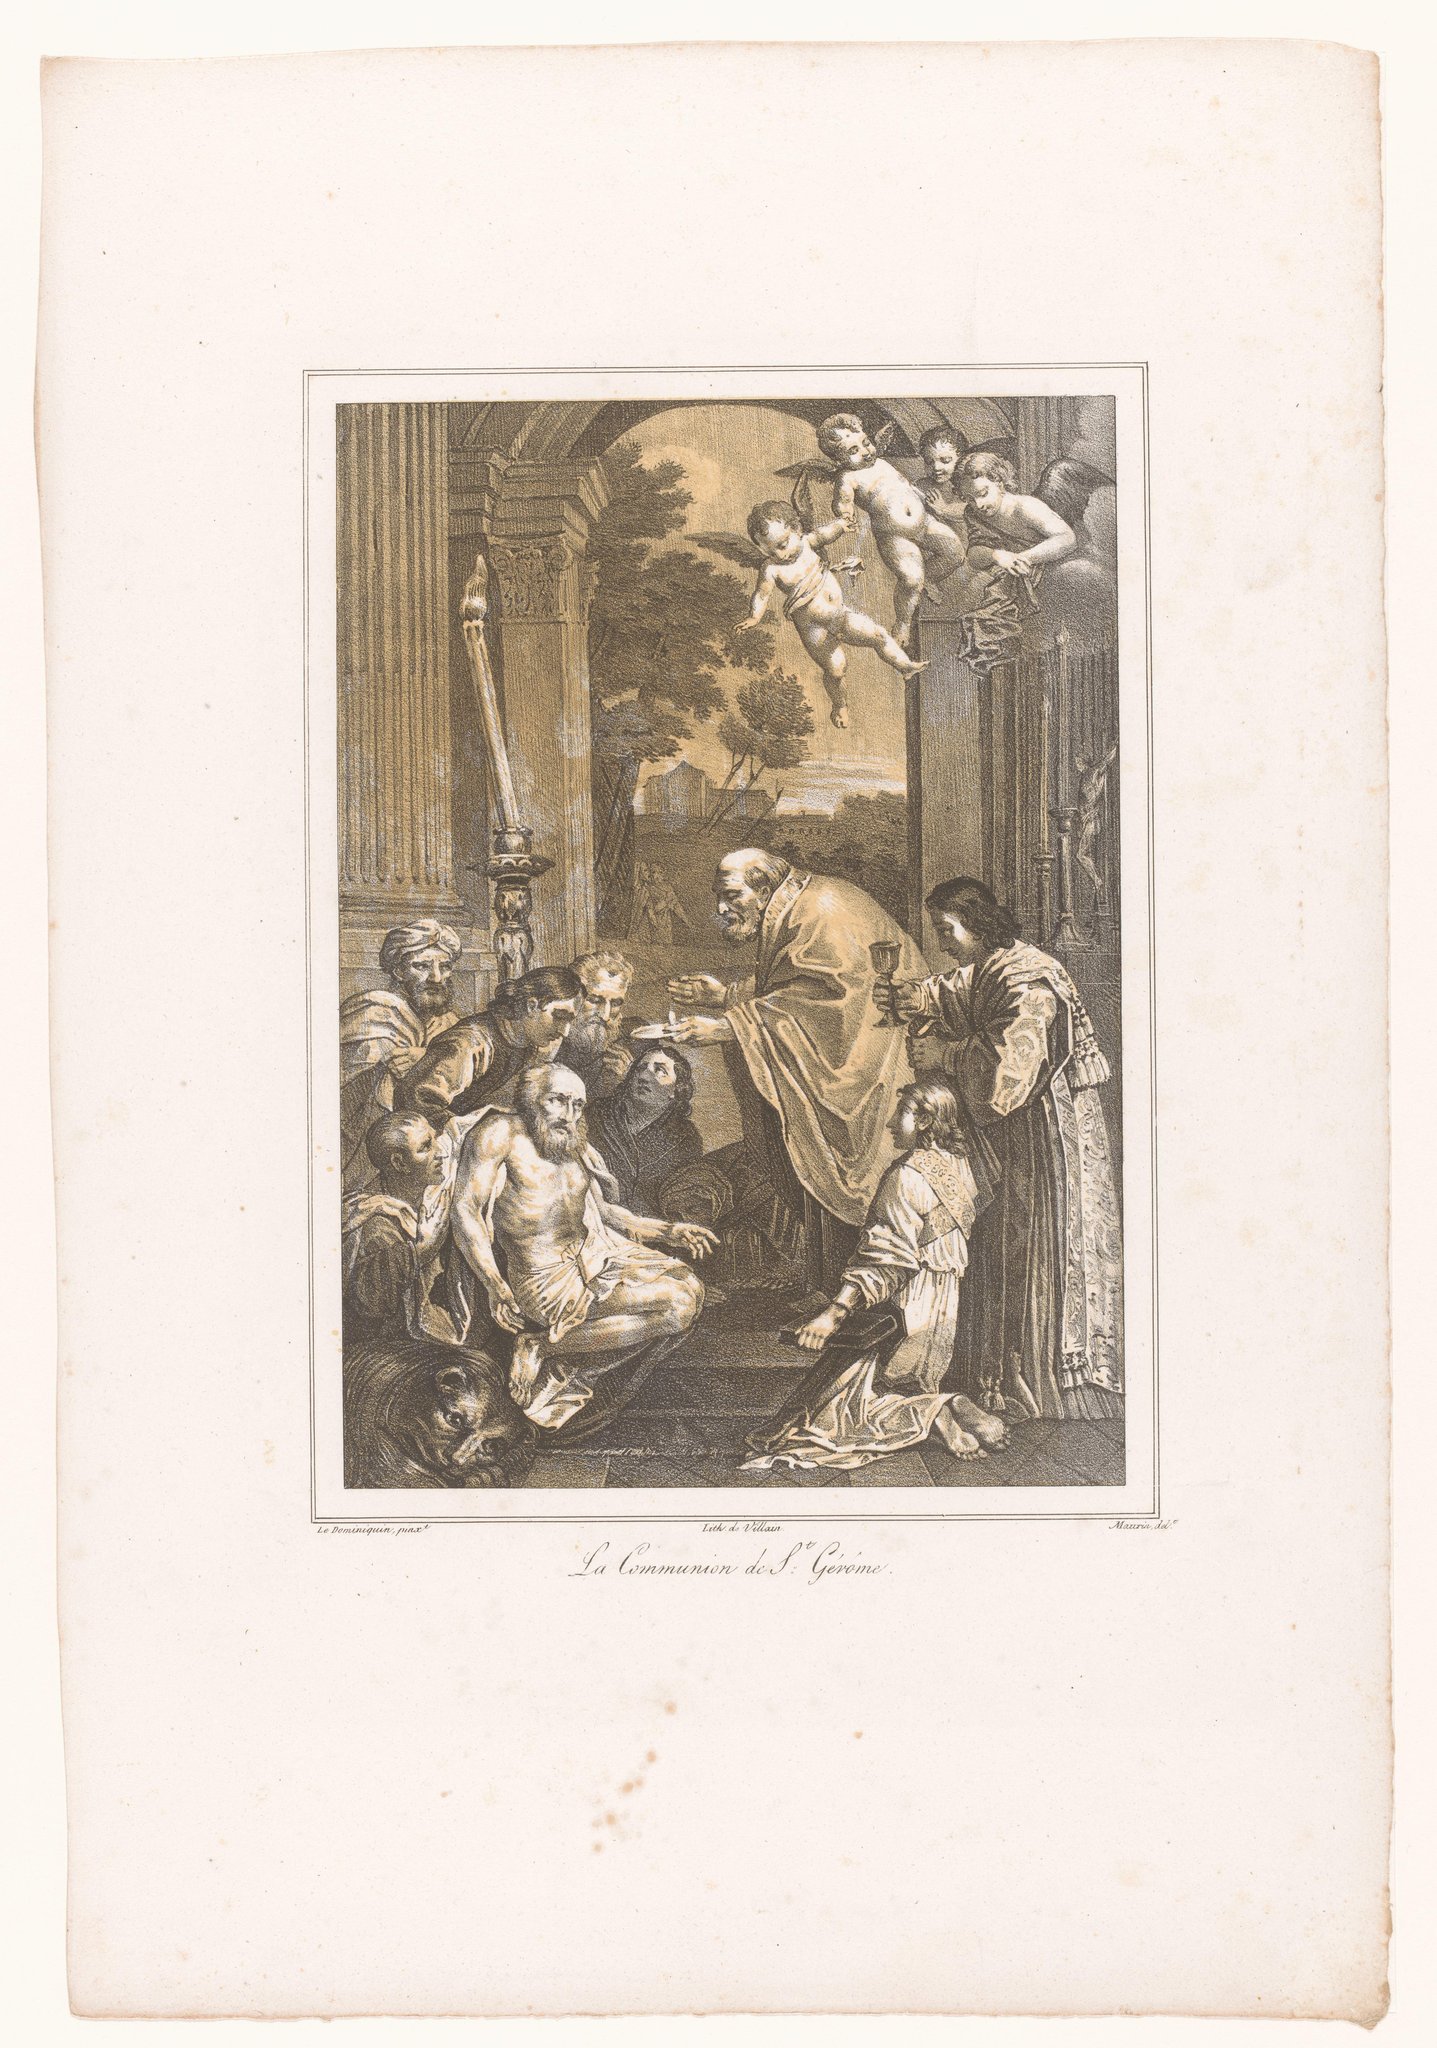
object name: print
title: De laatste communie van Sint-Hieronymus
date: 1825-1852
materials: paper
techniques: tone lithography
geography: paris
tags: eusebius hieronymus, the last communion of st. jerome: he is attended and supported by younger priests, one of whom is about to administer the sacrament; usually st. paula is present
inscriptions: check stamp: ‘JC’, collector's mark: Lugt 2233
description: Prent ook gebruikt in: Chabert, Jean Claude. Galerie des peintres ou collection de portraits des peintres les plus célèbres de toutes les écoles. Accompagnée d'une notice sur chacun d'eux, et de copies de dessins originaux / Galerie des peintres ou collection de portraits des peintres les plus célèbres de toutes les écoles. Accompagnée de leur notice historique, de leurs dessins et d'un discours sur les arts. Parijs: Jean Claude Chabert, s.a. [1822-1834]. De samenstelling van tegenwoordig bekende en al dan niet gebonden exemplaren van deze uitgave verschillen. Dit omdat de prenten en bijhorende stukken tekst op inschrijving en waarschijnlijk ook los verkrijgbaar waren.